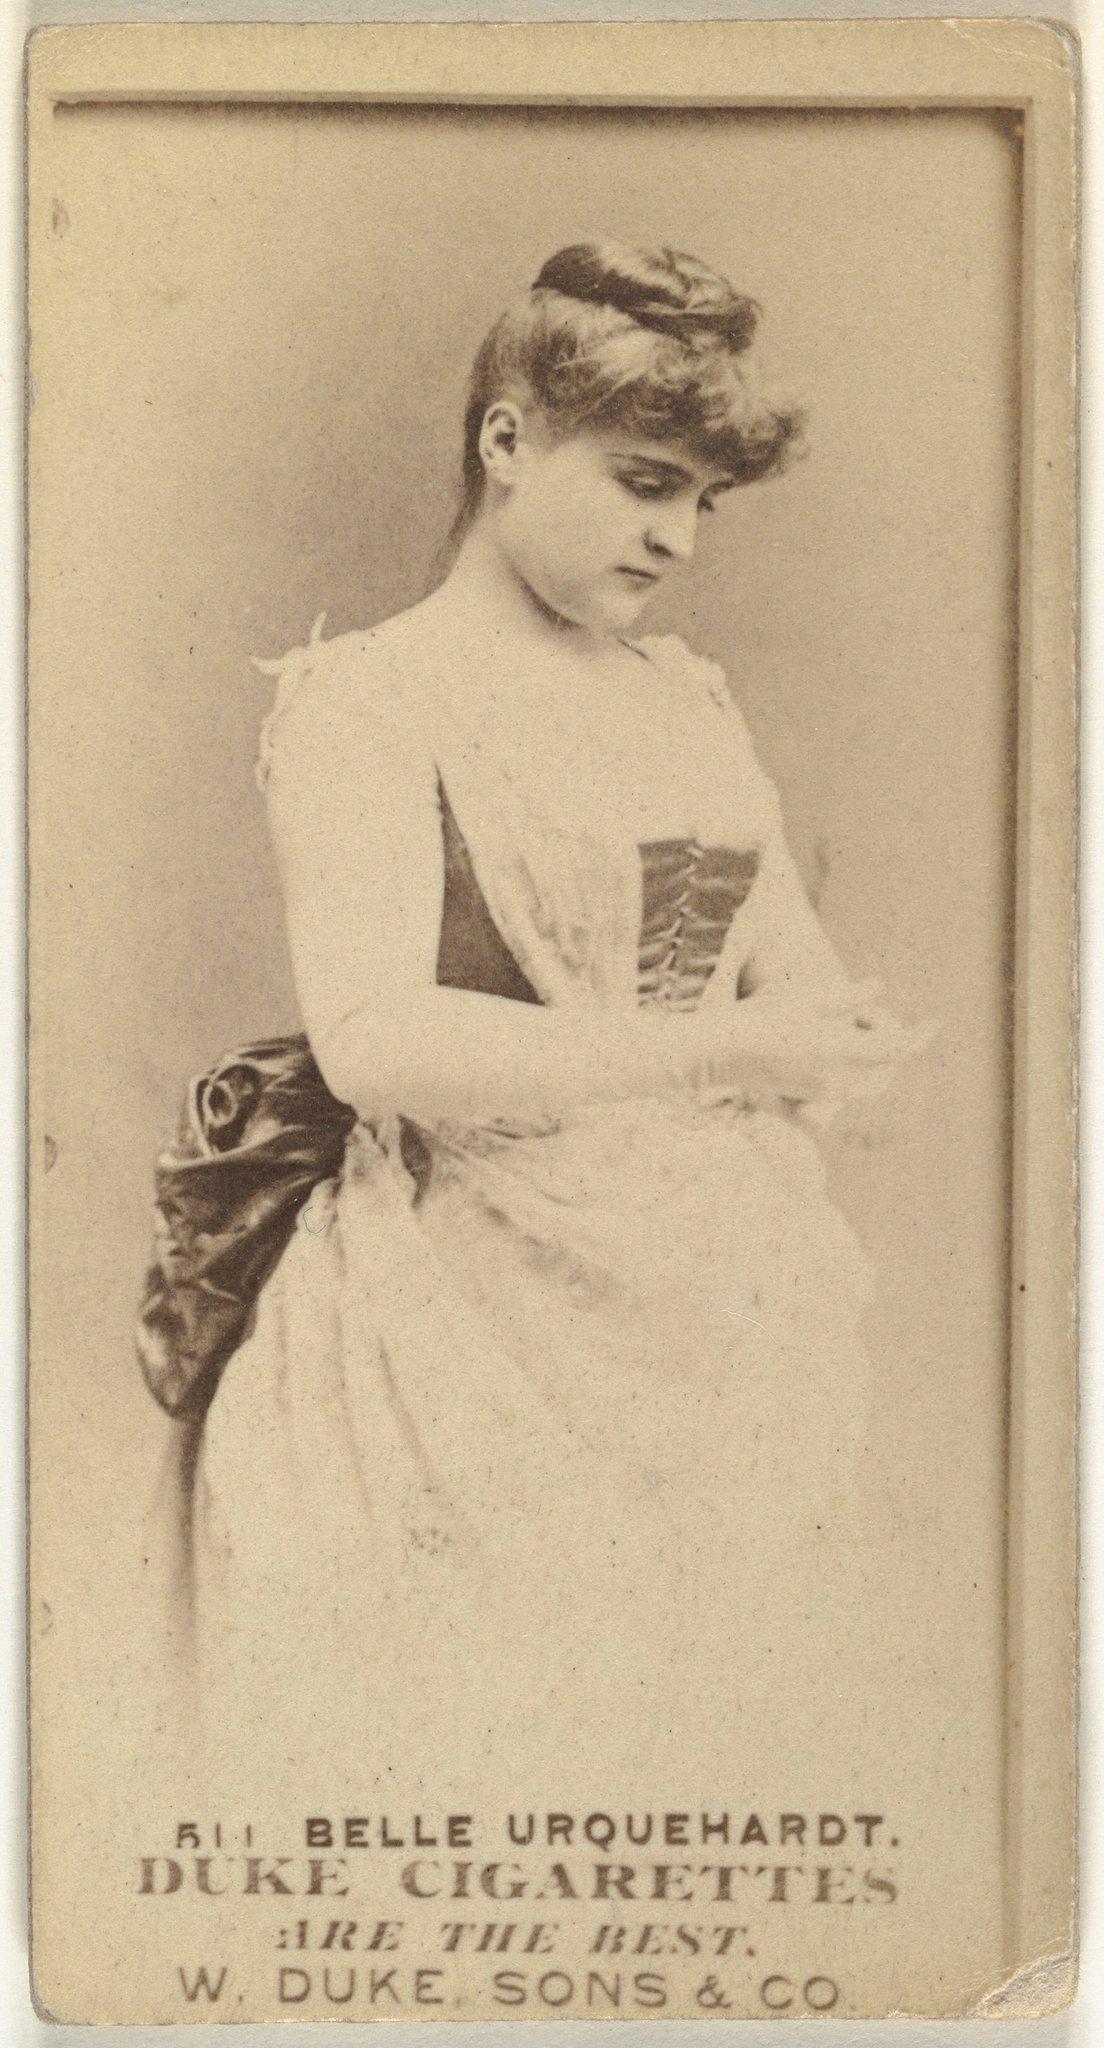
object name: photograph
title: Card Number 511, Belle Urquehardt, from the Actors and Actresses series (N145-7) issued by Duke Sons & Co. to promote Duke Cigarettes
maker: w. duke, sons & co.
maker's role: publisher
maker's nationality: american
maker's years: 1870-1920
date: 1880-1889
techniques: albumen silver print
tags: portraits,women,actresses